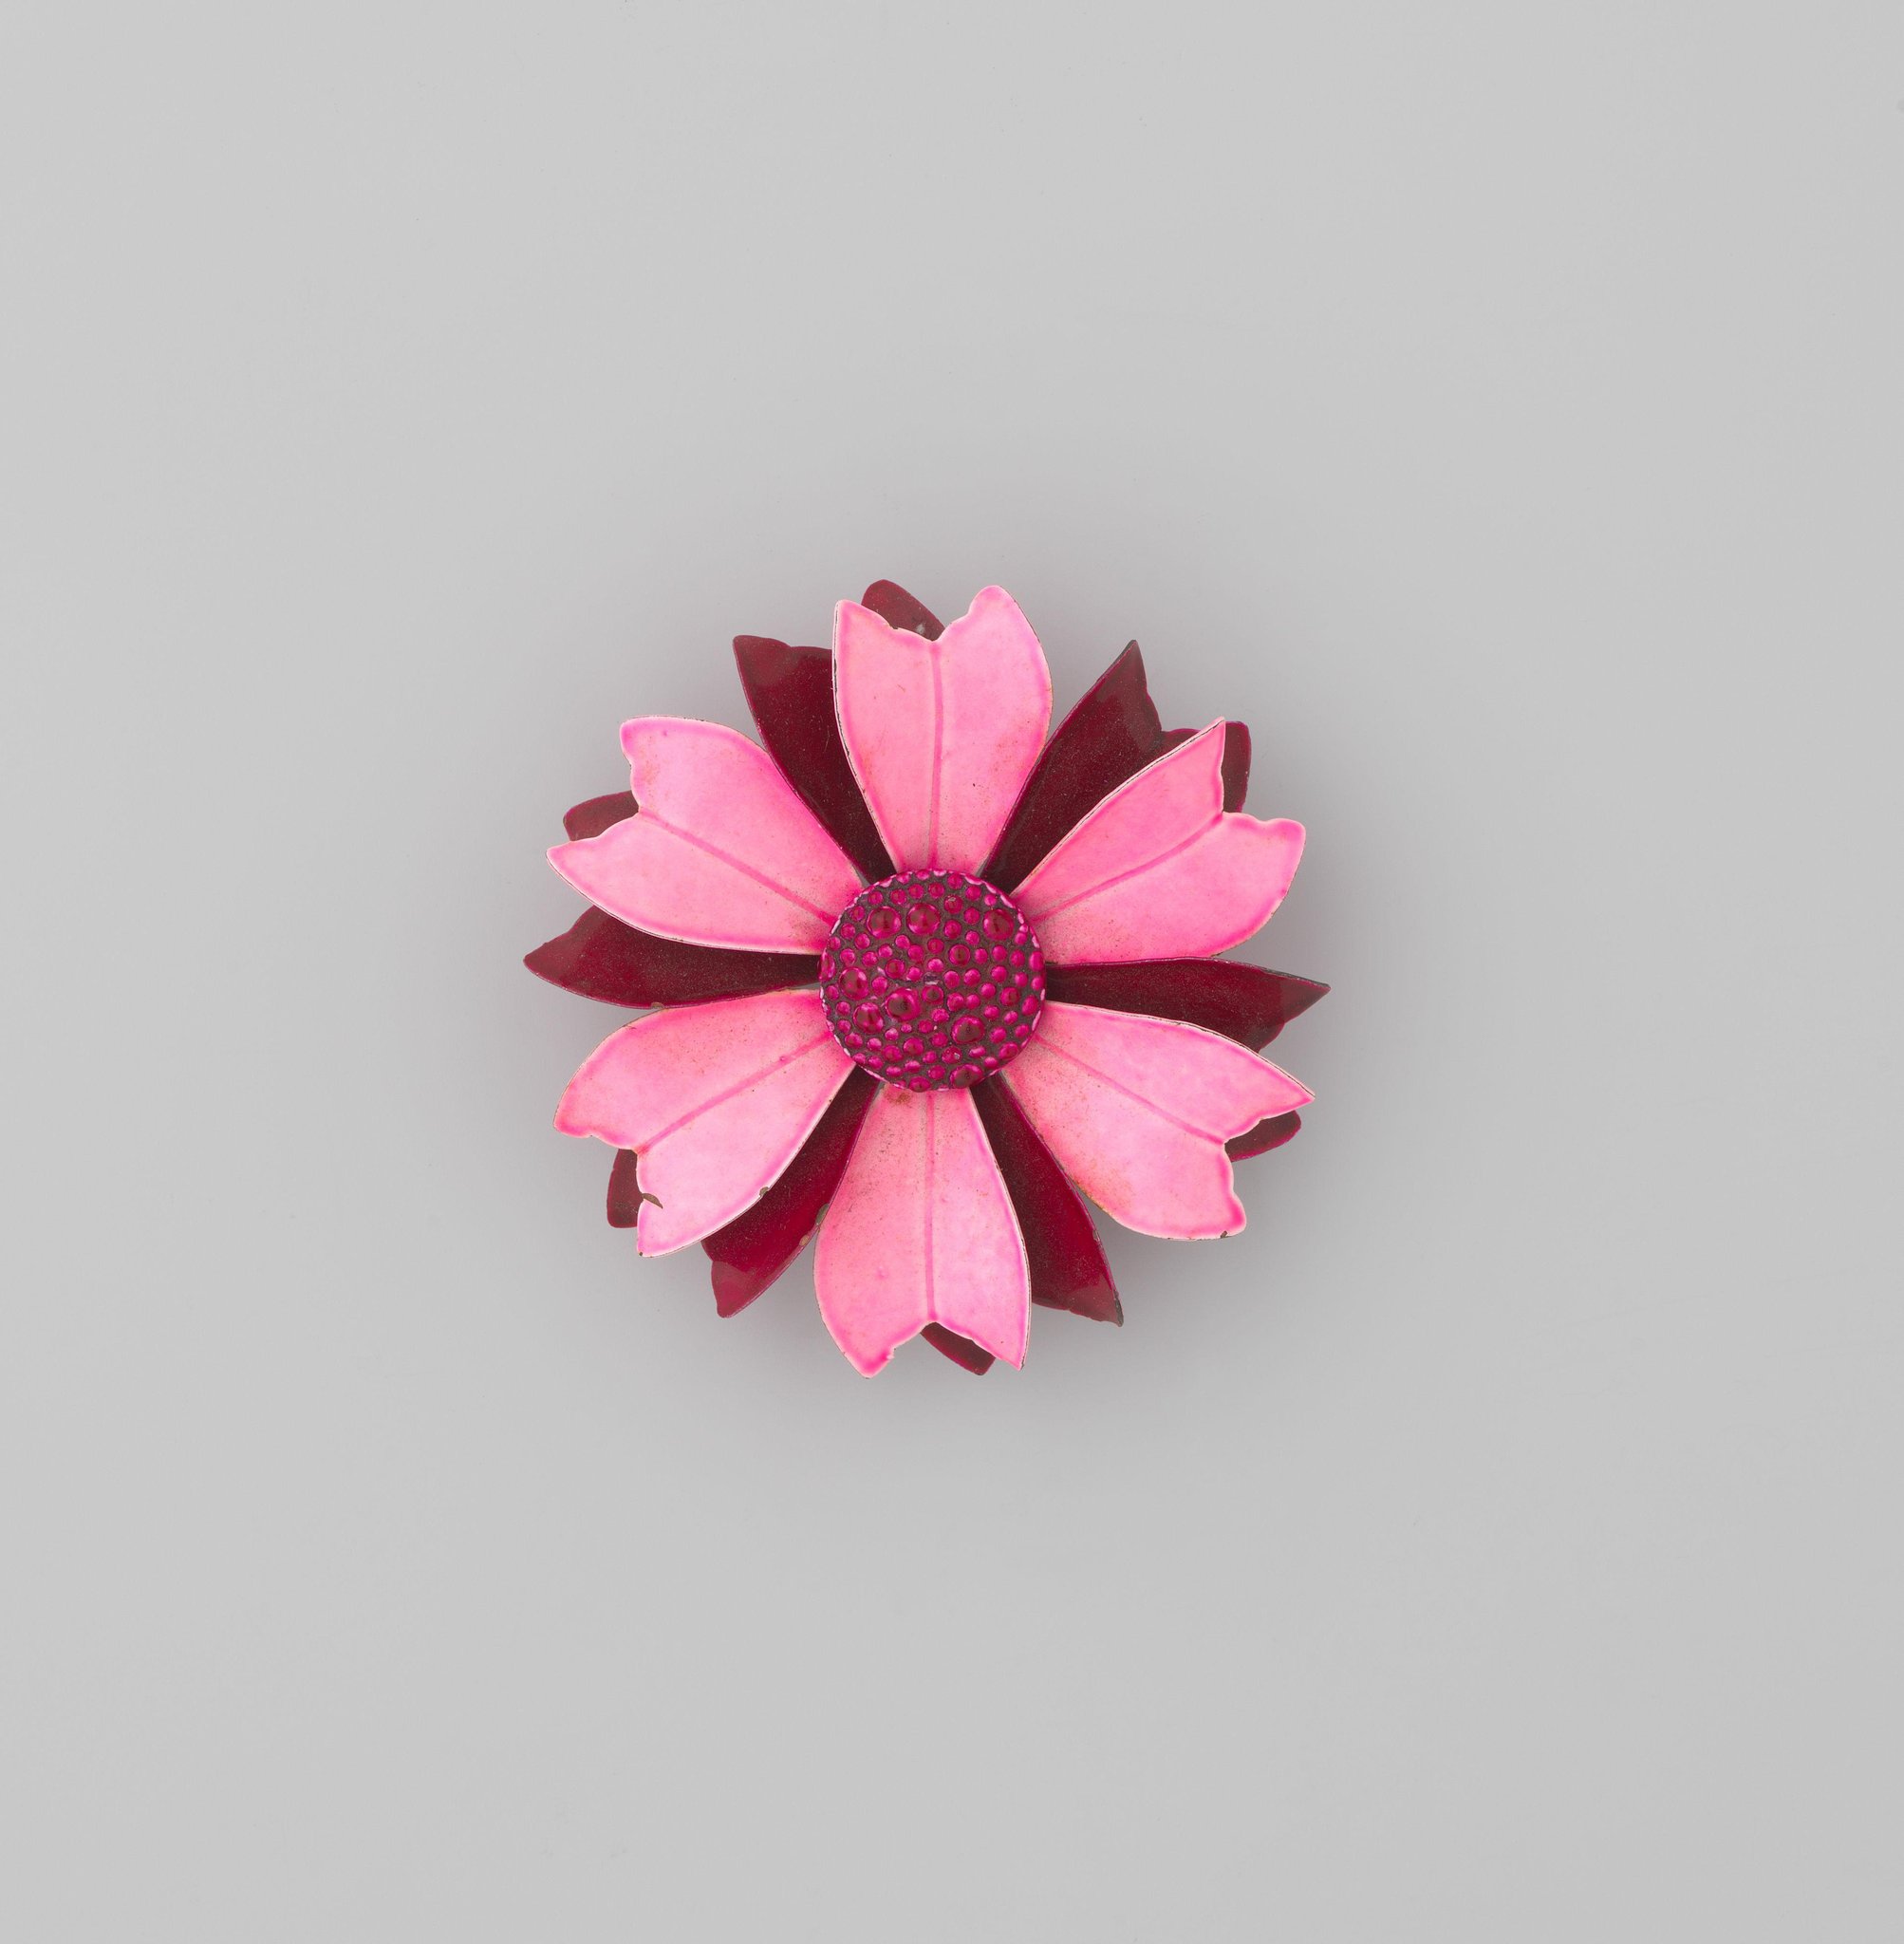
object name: brooch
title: Broche in de vorm van een bloem in roze met rood geëmailleerd metaal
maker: Anonymous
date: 1950-1970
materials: metal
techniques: enameling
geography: netherlands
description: Broche in de vorm van een bloem in roze met rood geëmailleerd metaal voorzien van een kogelsluiting.